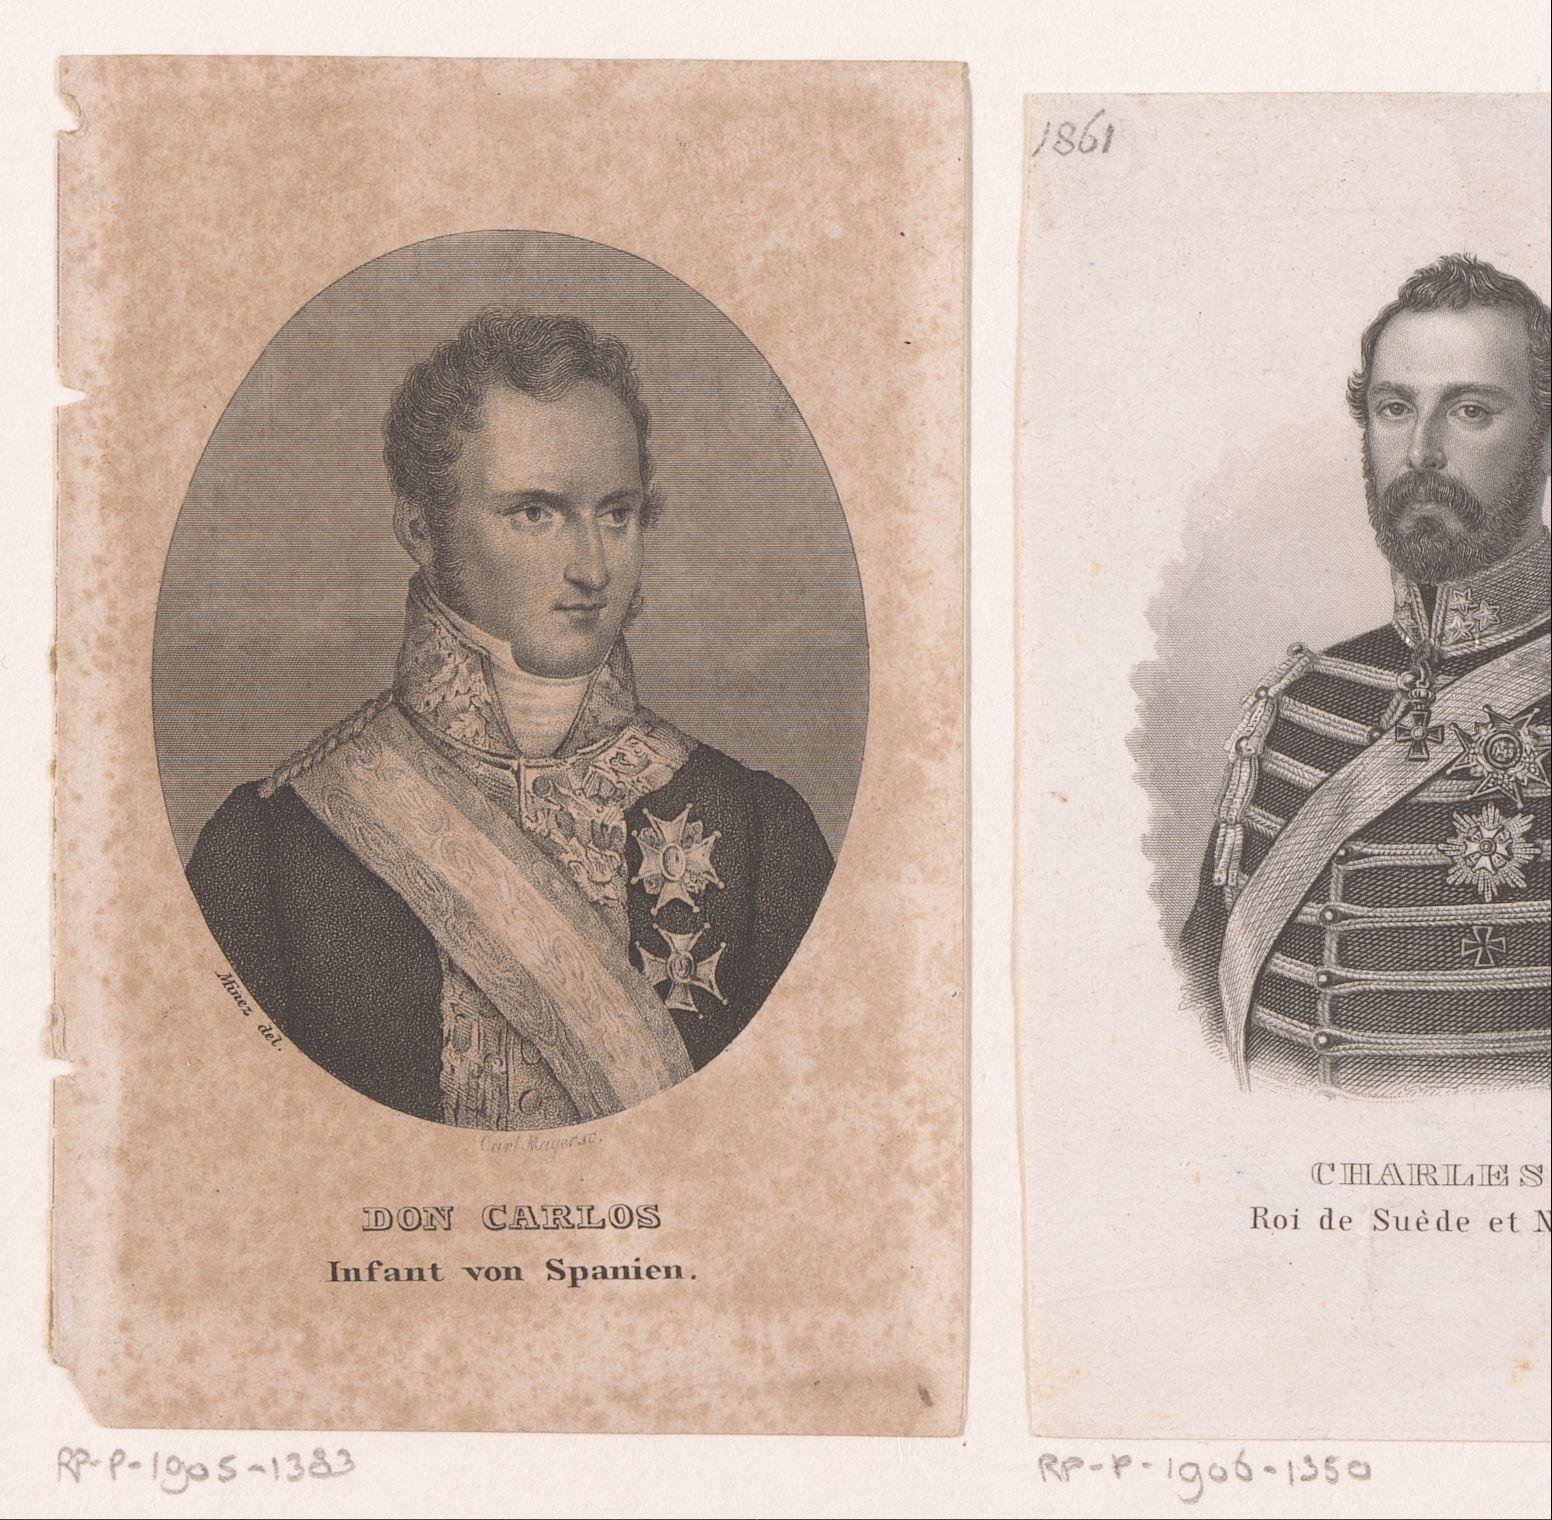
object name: book illustration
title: Portret van Carlos María Isidro Benito de Borbón y Borbón-Parma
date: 1836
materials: paper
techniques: engraving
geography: nuremberg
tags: earl, historical persons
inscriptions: collector's mark: Lugt 2228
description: Vermoedelijk afkomstig uit: Almanach de Gotha, 1836.